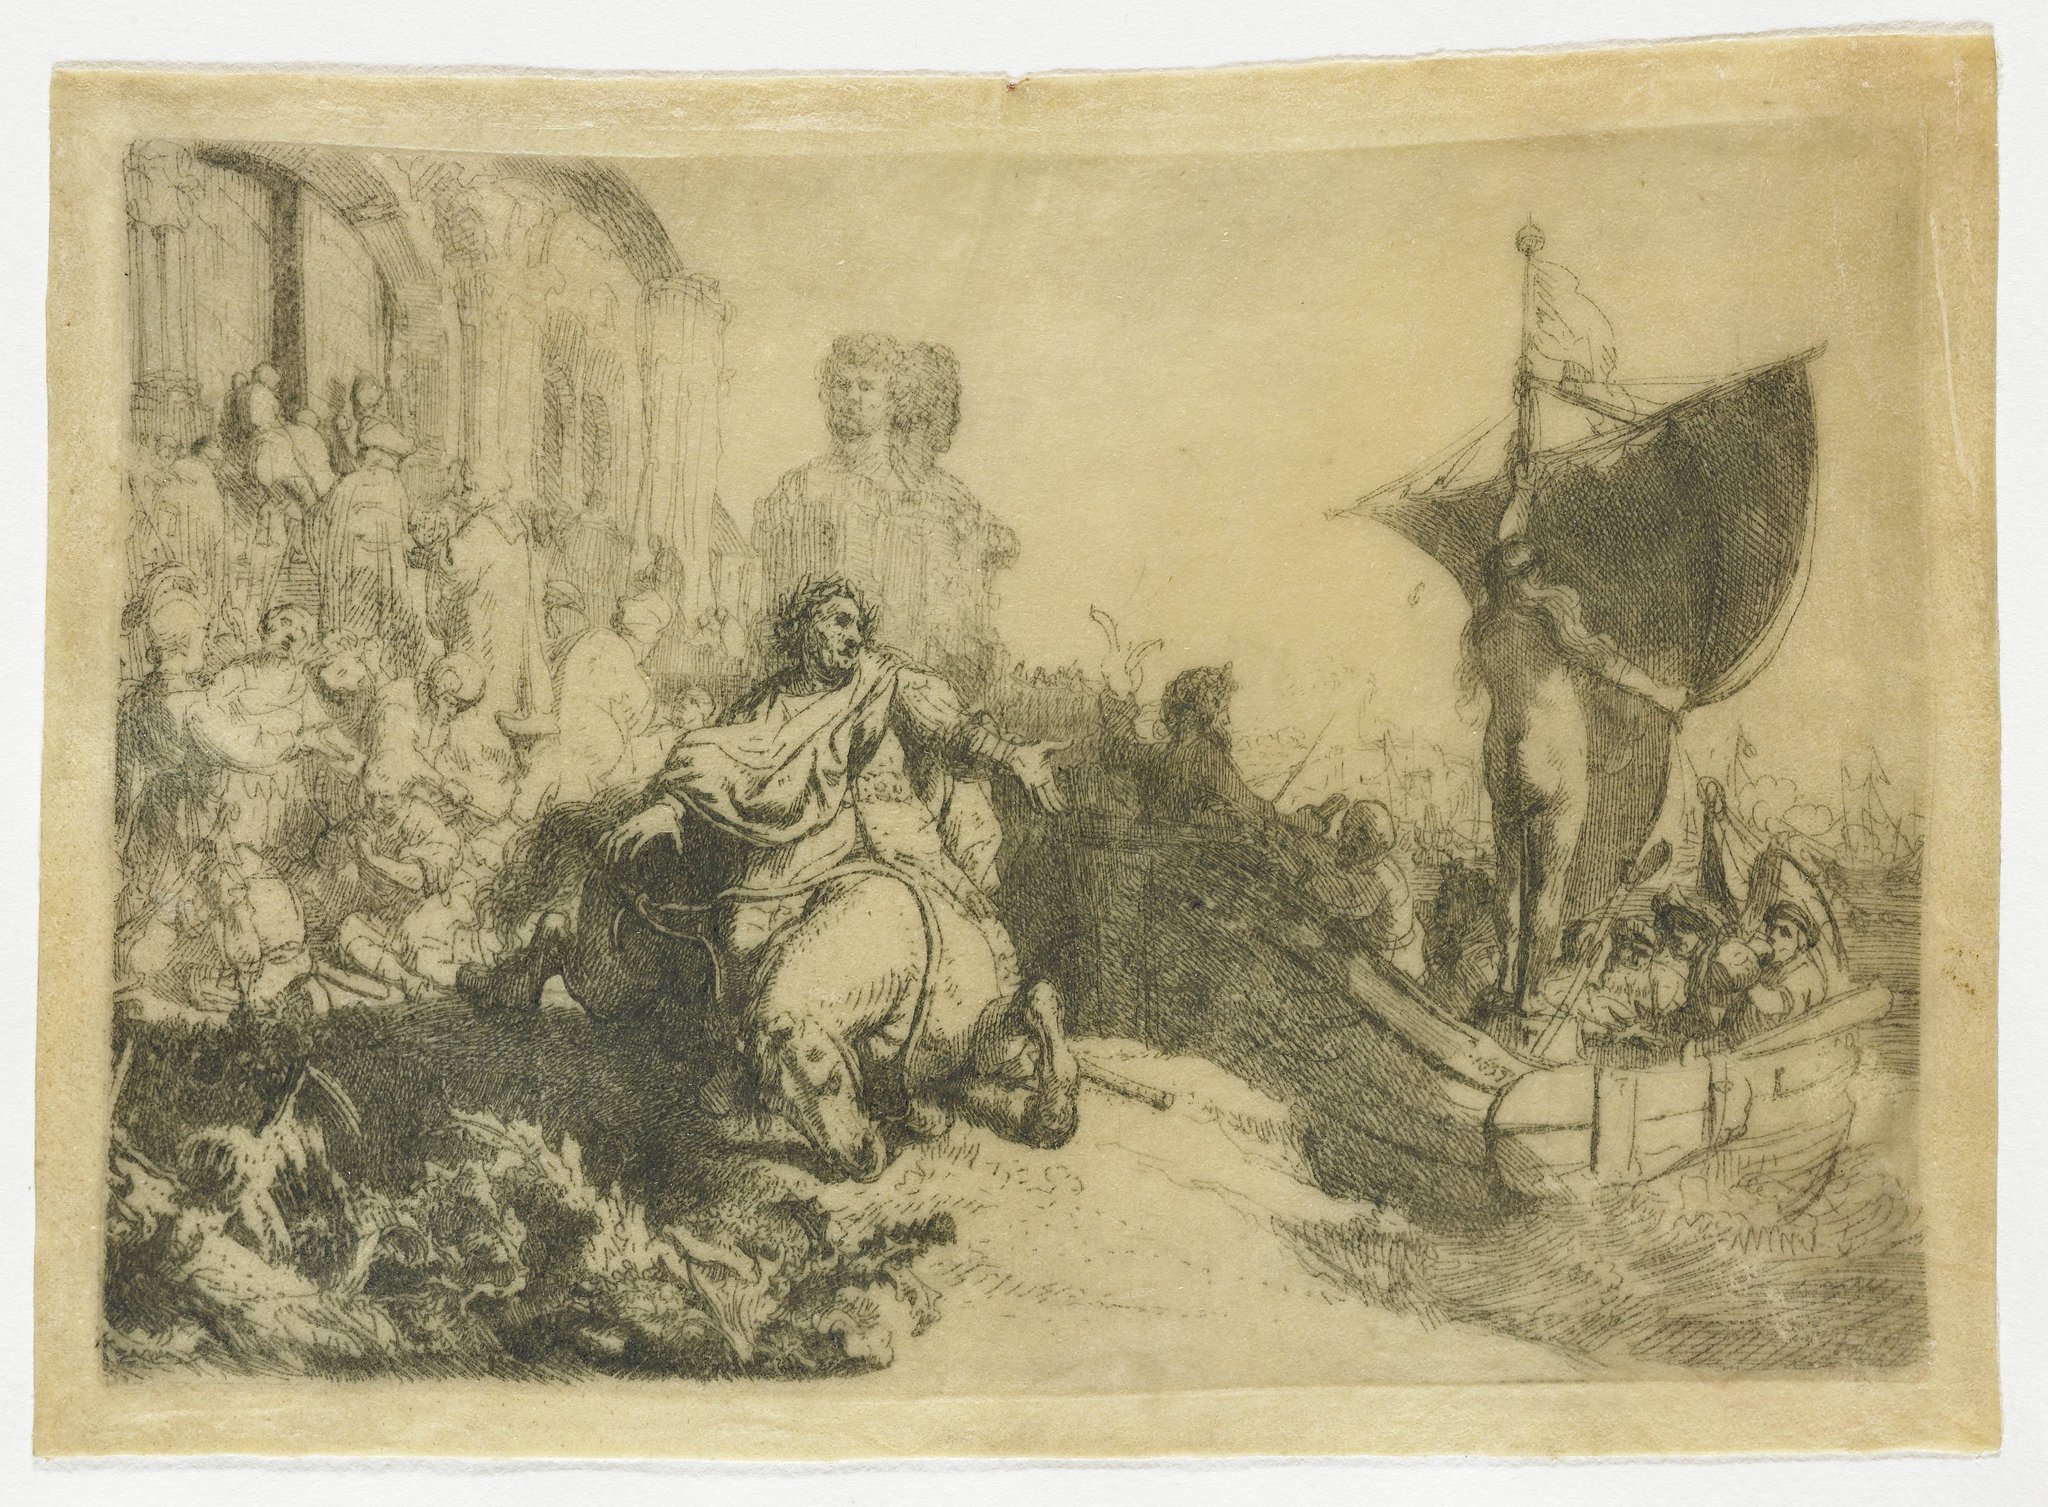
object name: print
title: The Ship of Fortune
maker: rembrandt van rijn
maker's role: draughtsman, painter, print maker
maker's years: 1606-1669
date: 1633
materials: parchment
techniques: etching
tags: at the sight of the ruins of carthage, c. marius talks with a lictor about the cruel vicissitudes of fortune, roman personifications of abstract concepts, luck, fortune, lot; 'fato', 'fortuna', 'fortuna aurea', 'fortuna buona', 'fortuna pacifica overo clemente', 'sorte' (ripa)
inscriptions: signature and date: ‘Rembrandt f. 1633’, collector's mark: Lugt 240